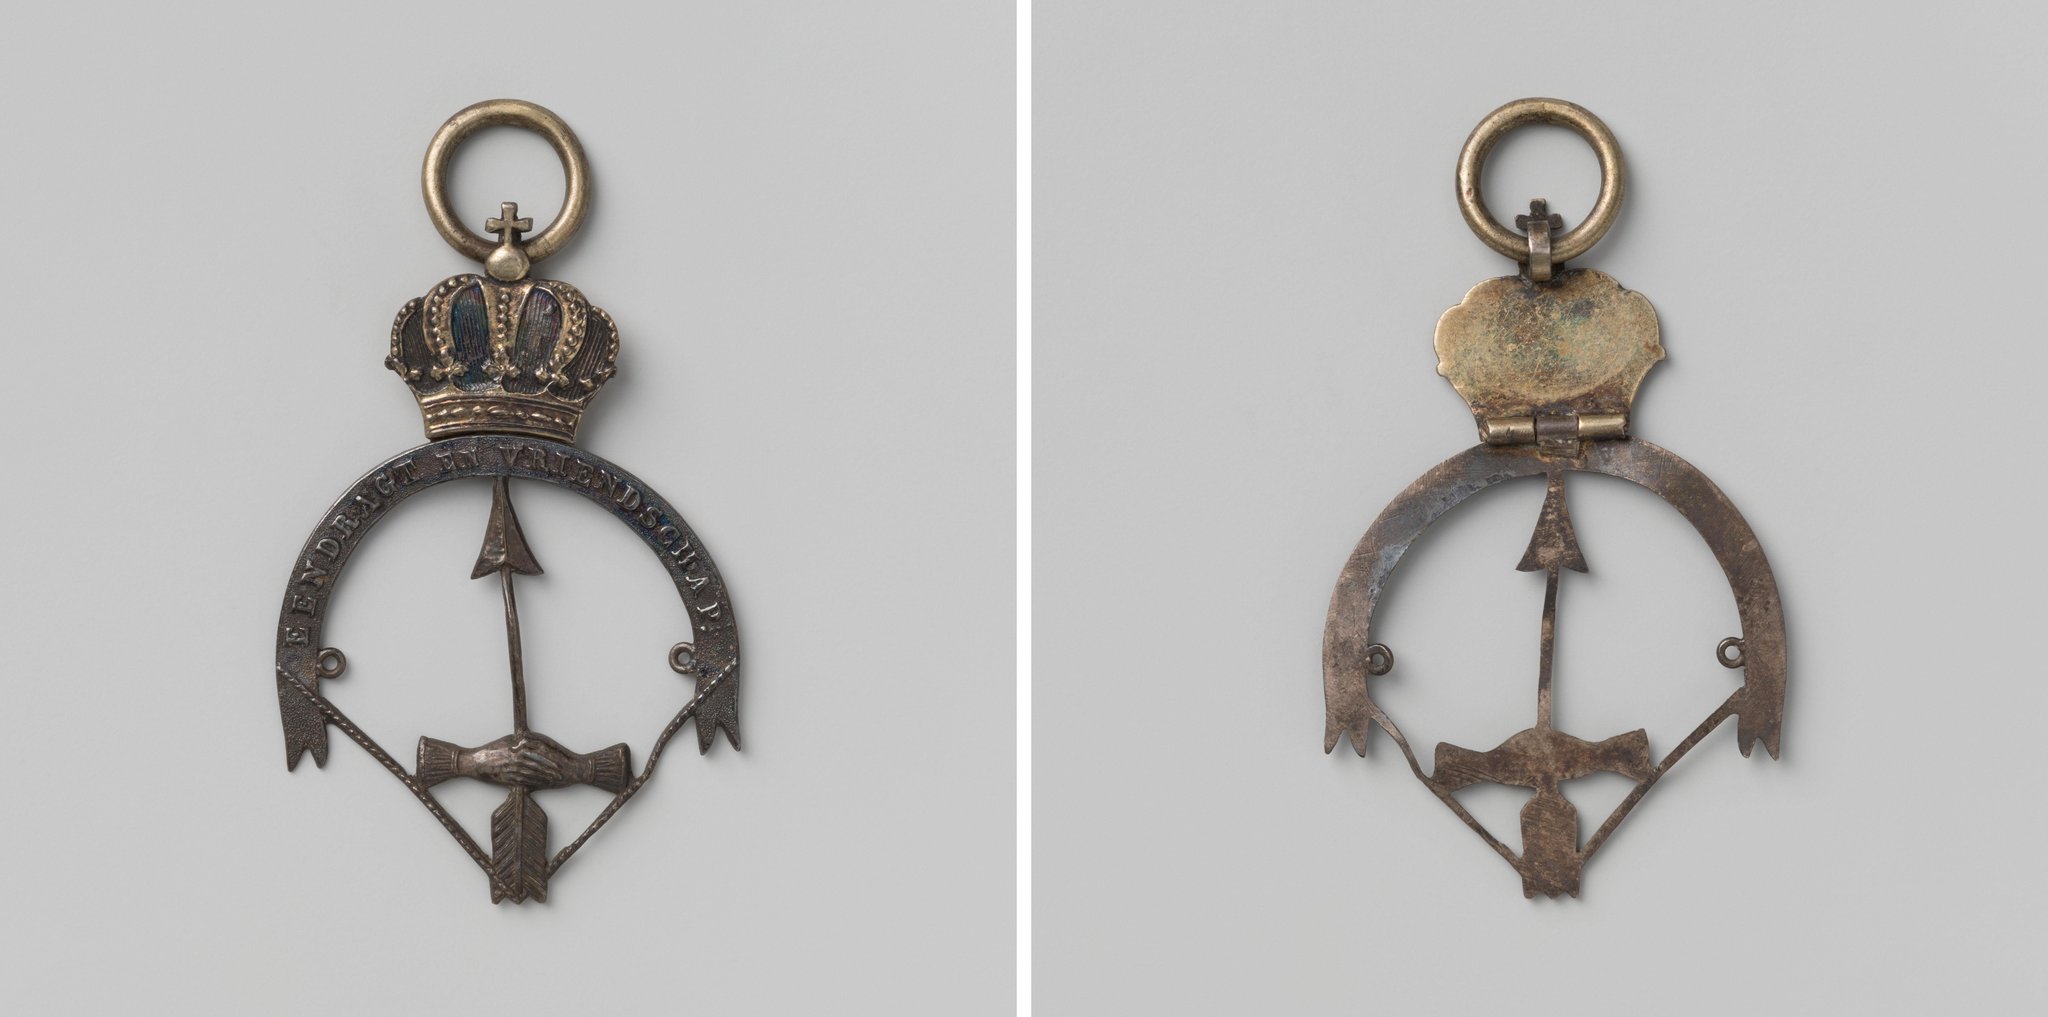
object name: insignia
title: Schuttersvereniging 'Eendracht en Vriendschap' te Amsterdam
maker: Anonymous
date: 1856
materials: silver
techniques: gilding, striking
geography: amsterdam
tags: amsterdam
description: eenzijdig, opengwerkt insigne, opgebouwd uit lint met opschrift, in vorm van gespannen boog, waarop pijl ligt die door twee ineengeslagen handen wordt vastgehouden; aan bovenzijde van boog met scharnier kroon bevestigd aan draagoog en draagring